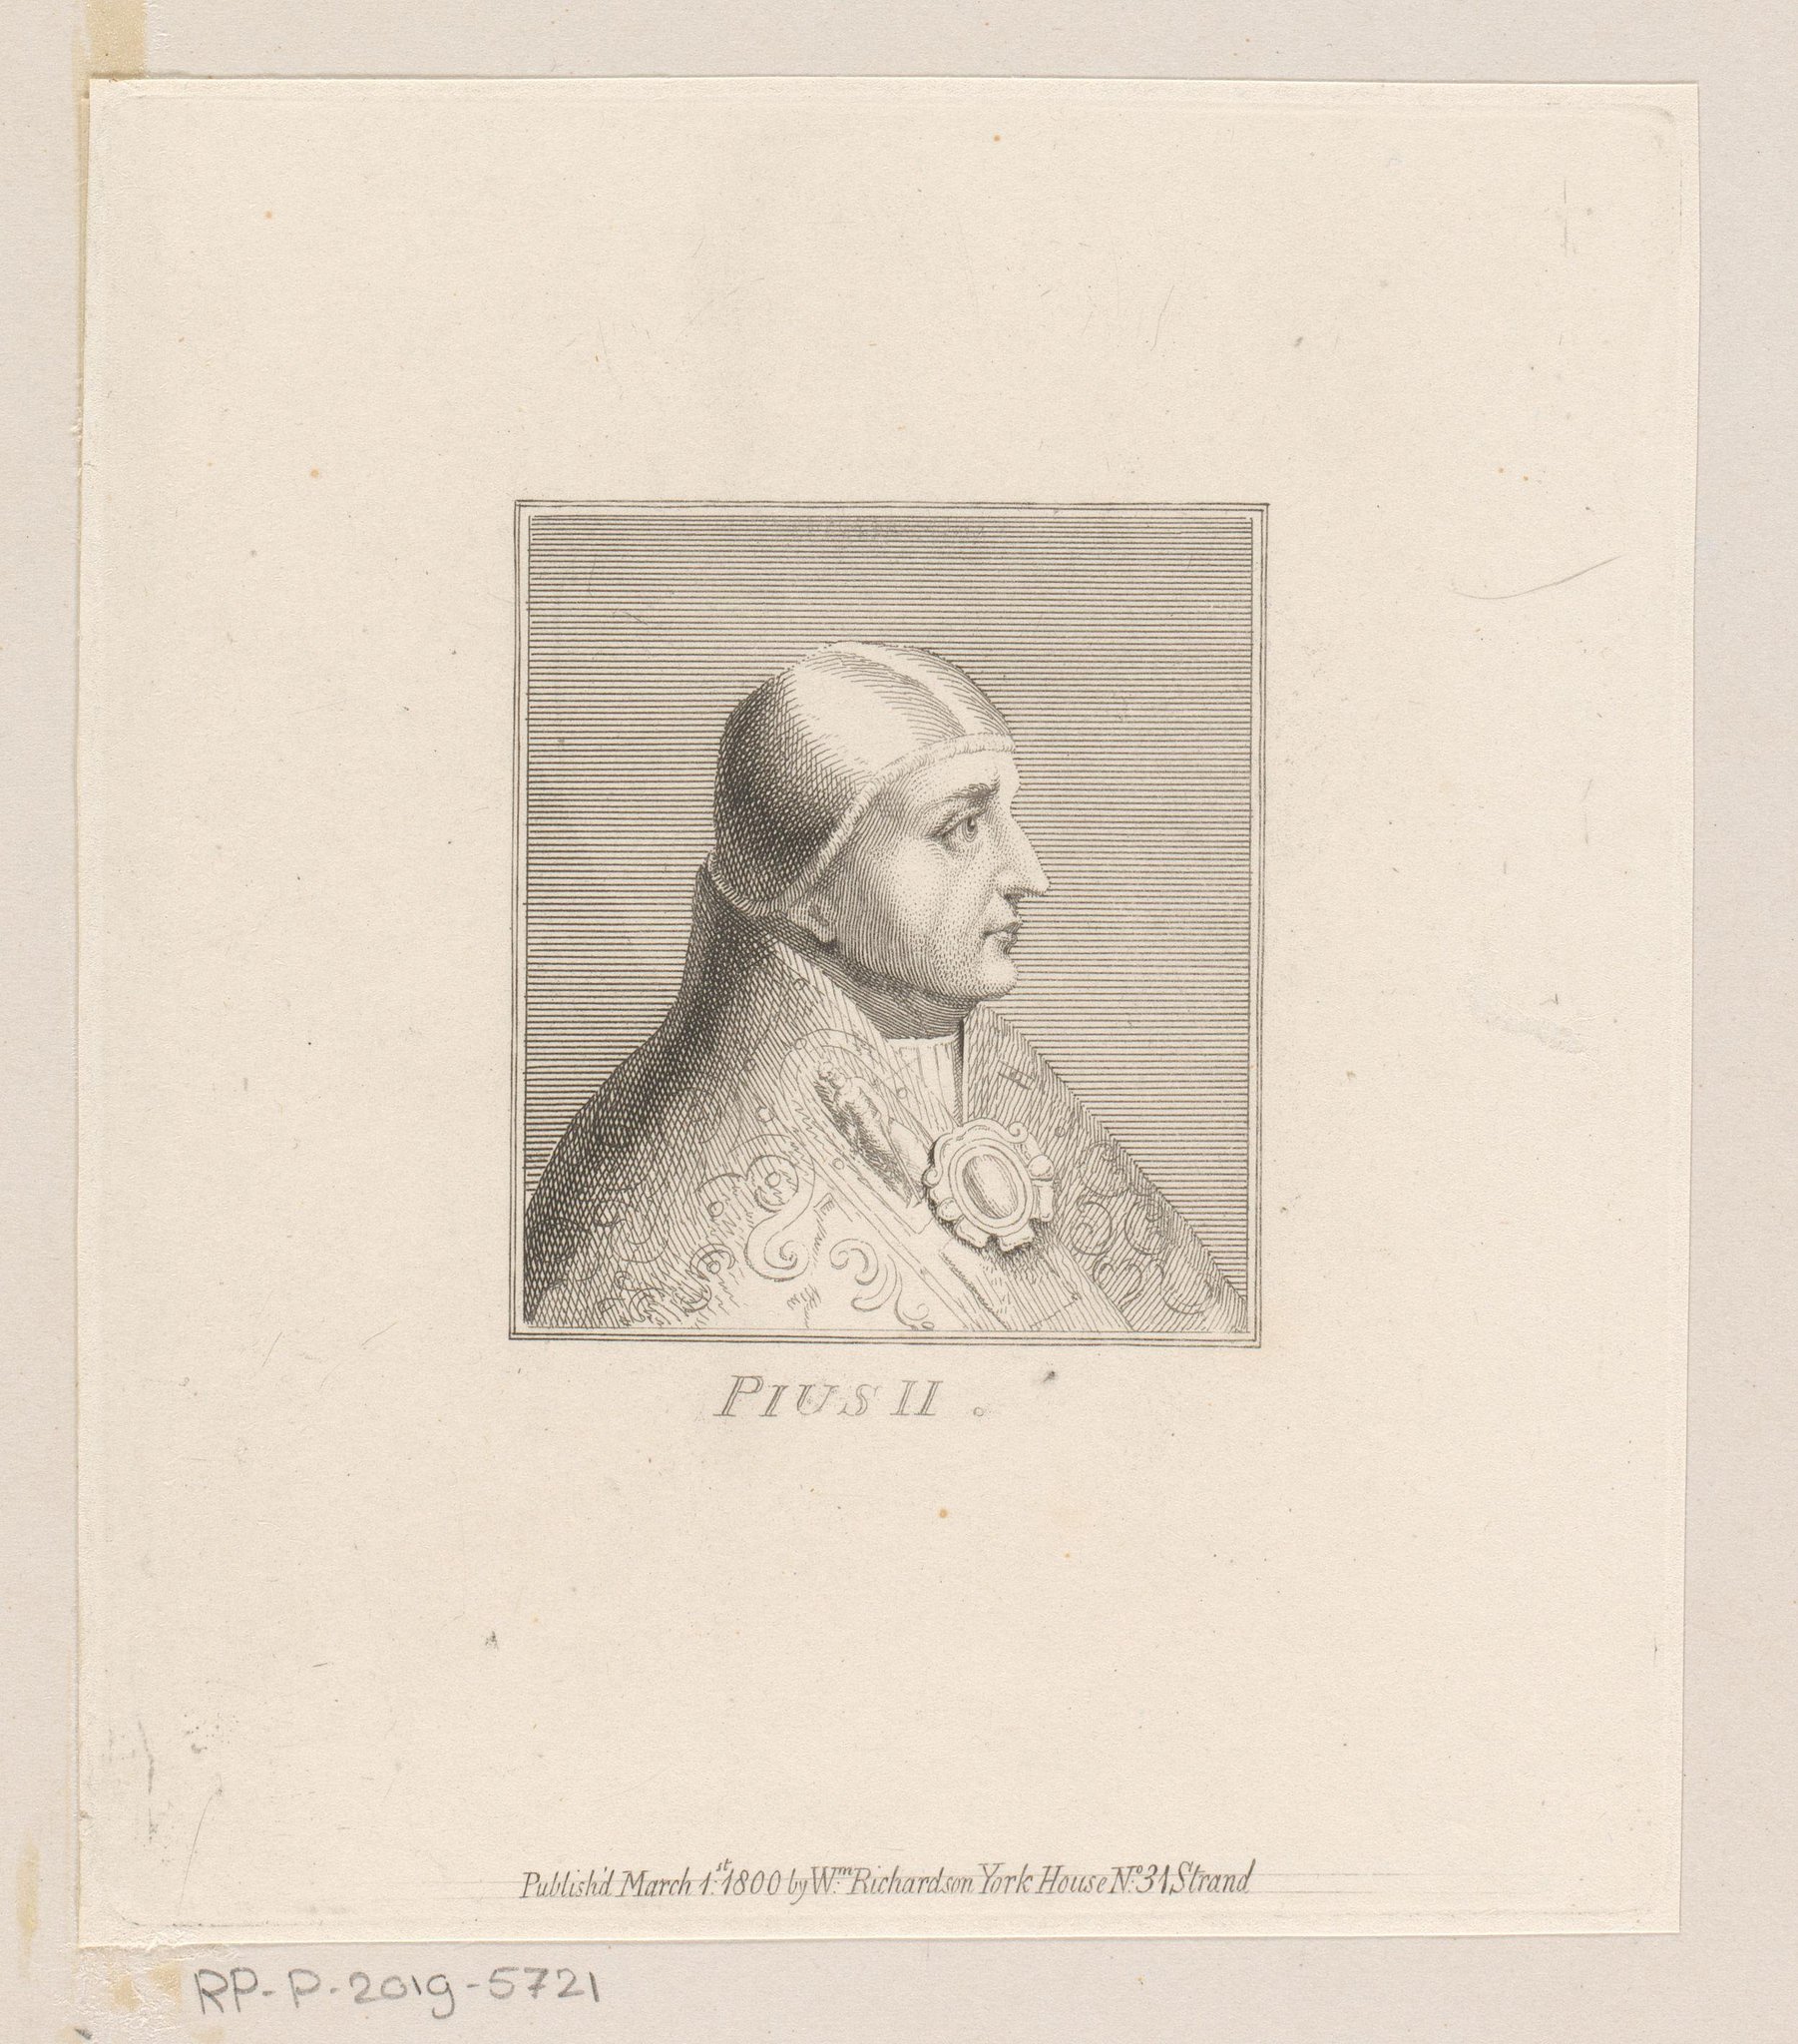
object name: print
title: Pius II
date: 1800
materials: paper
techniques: etching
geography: york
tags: rome, historical persons, pope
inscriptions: date